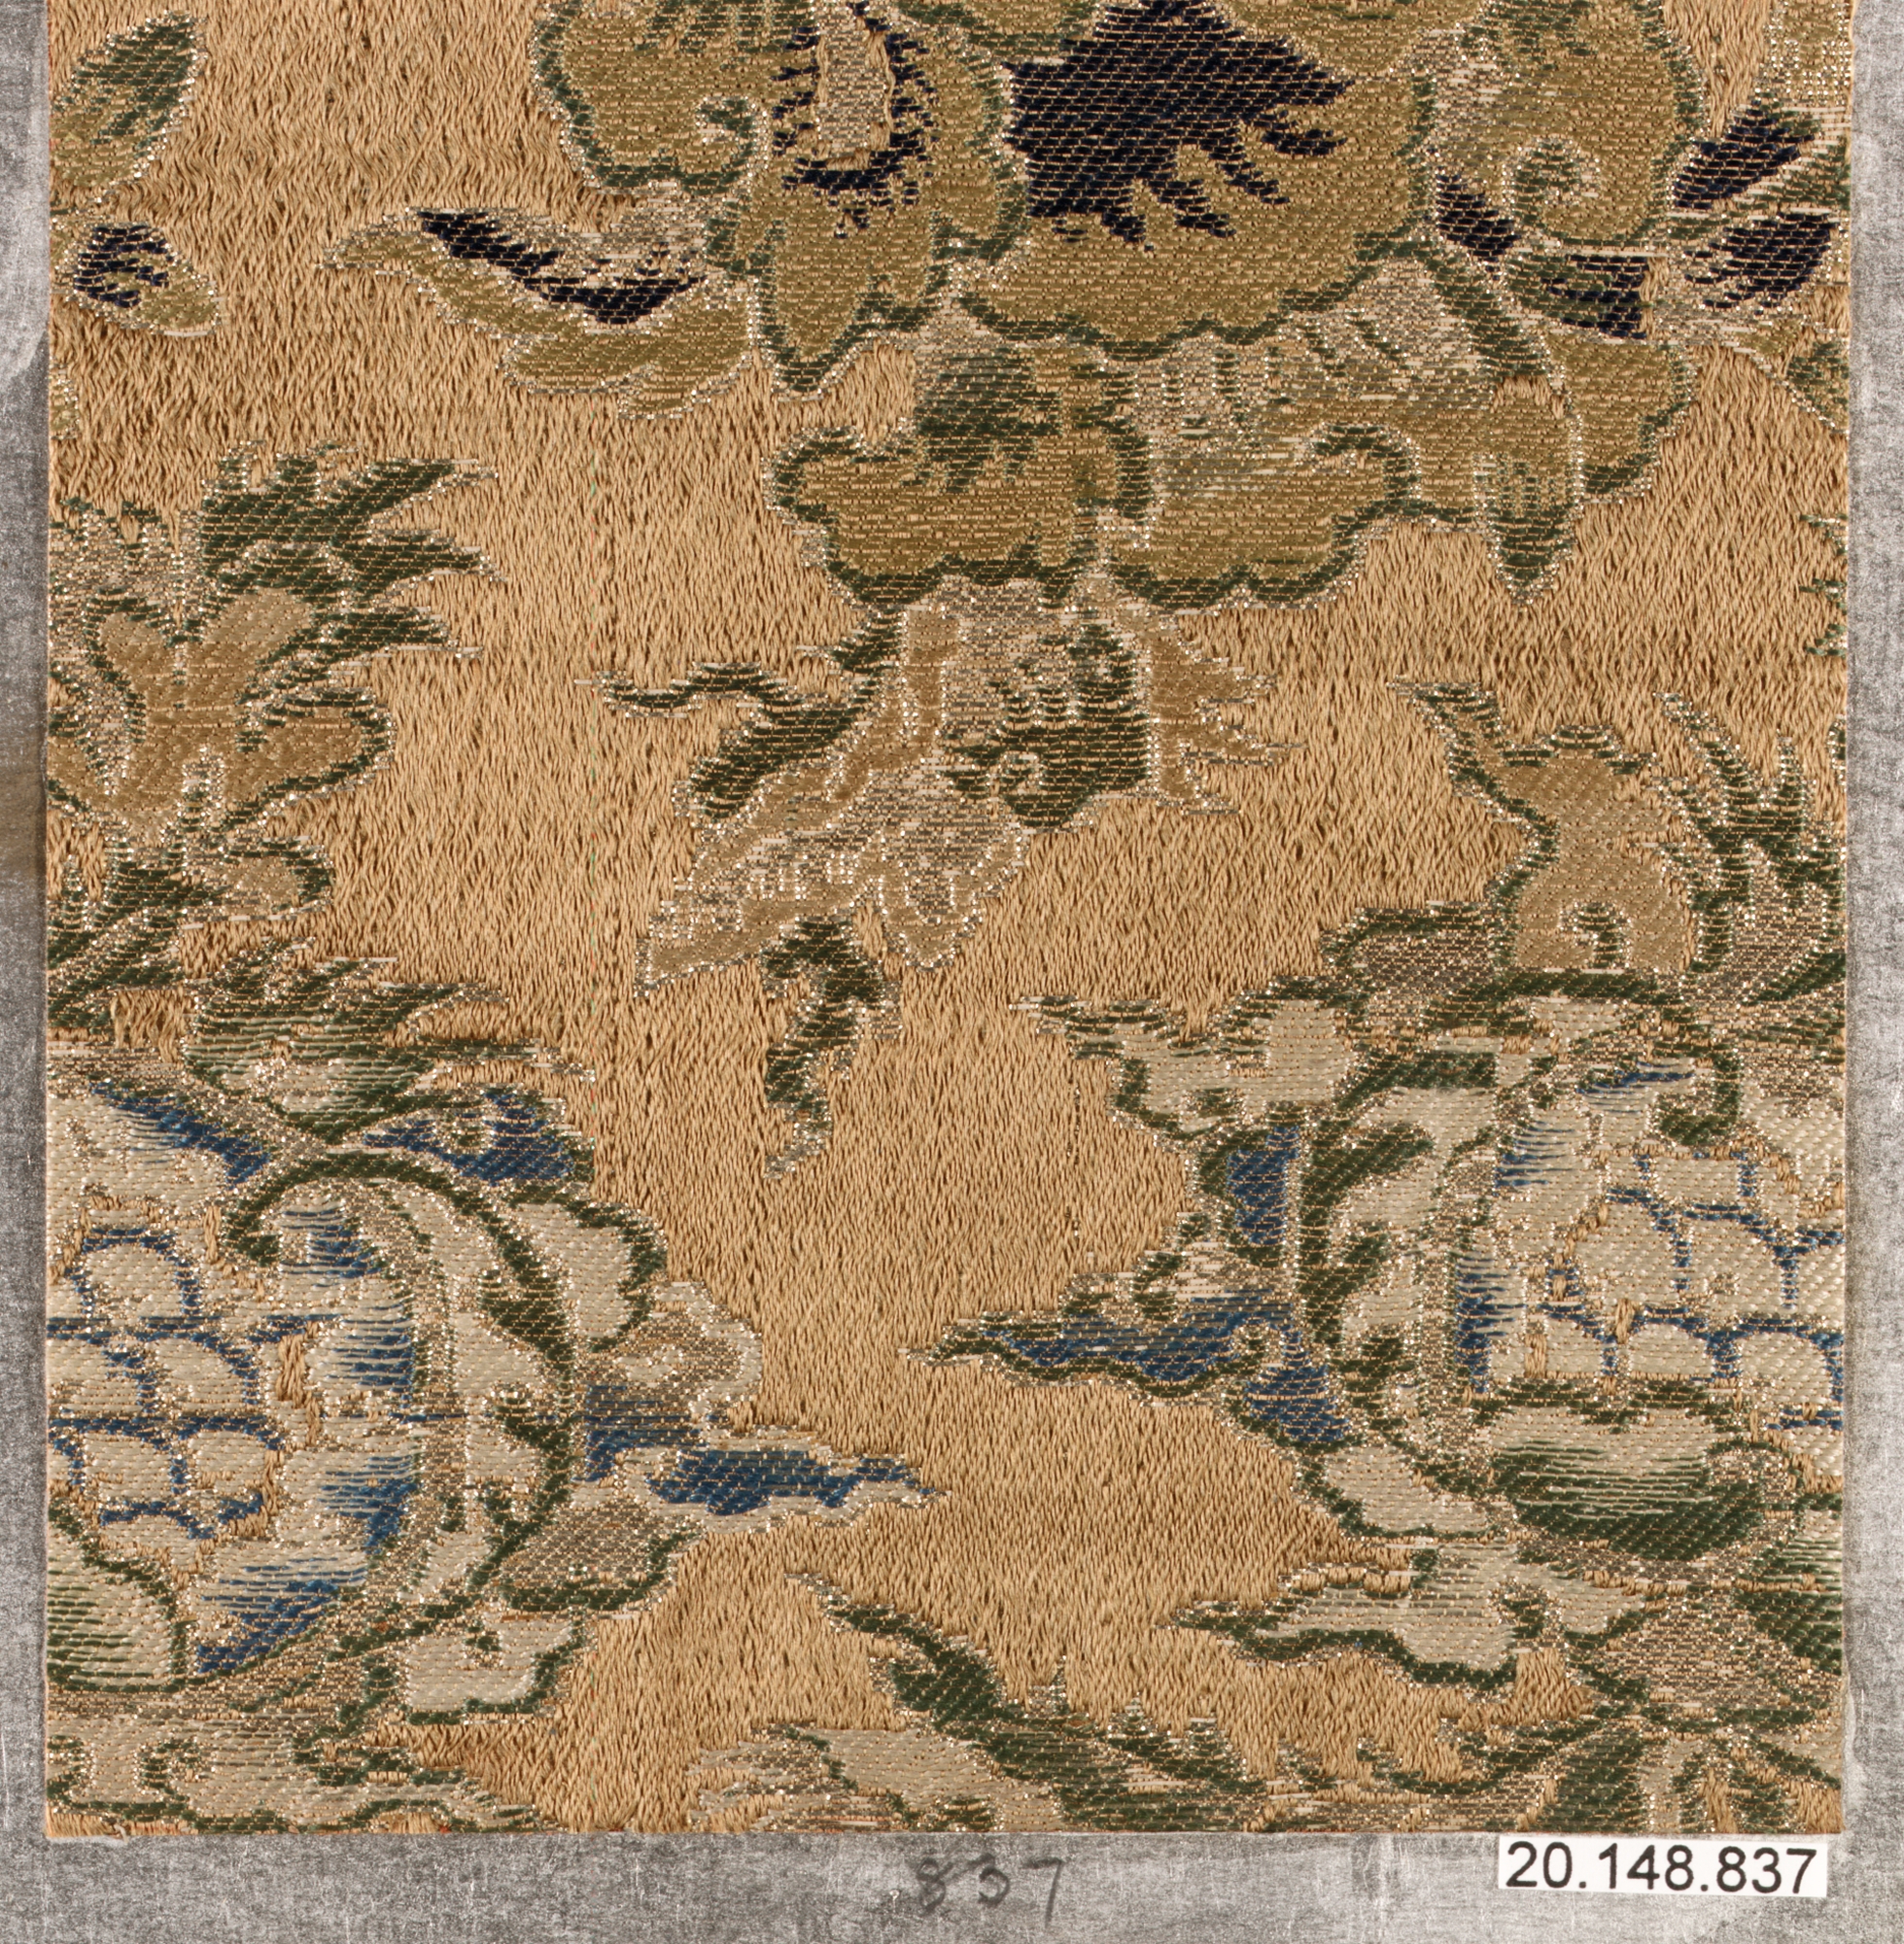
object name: piece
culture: japanese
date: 1701-1800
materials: silk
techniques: compound weave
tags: flowers